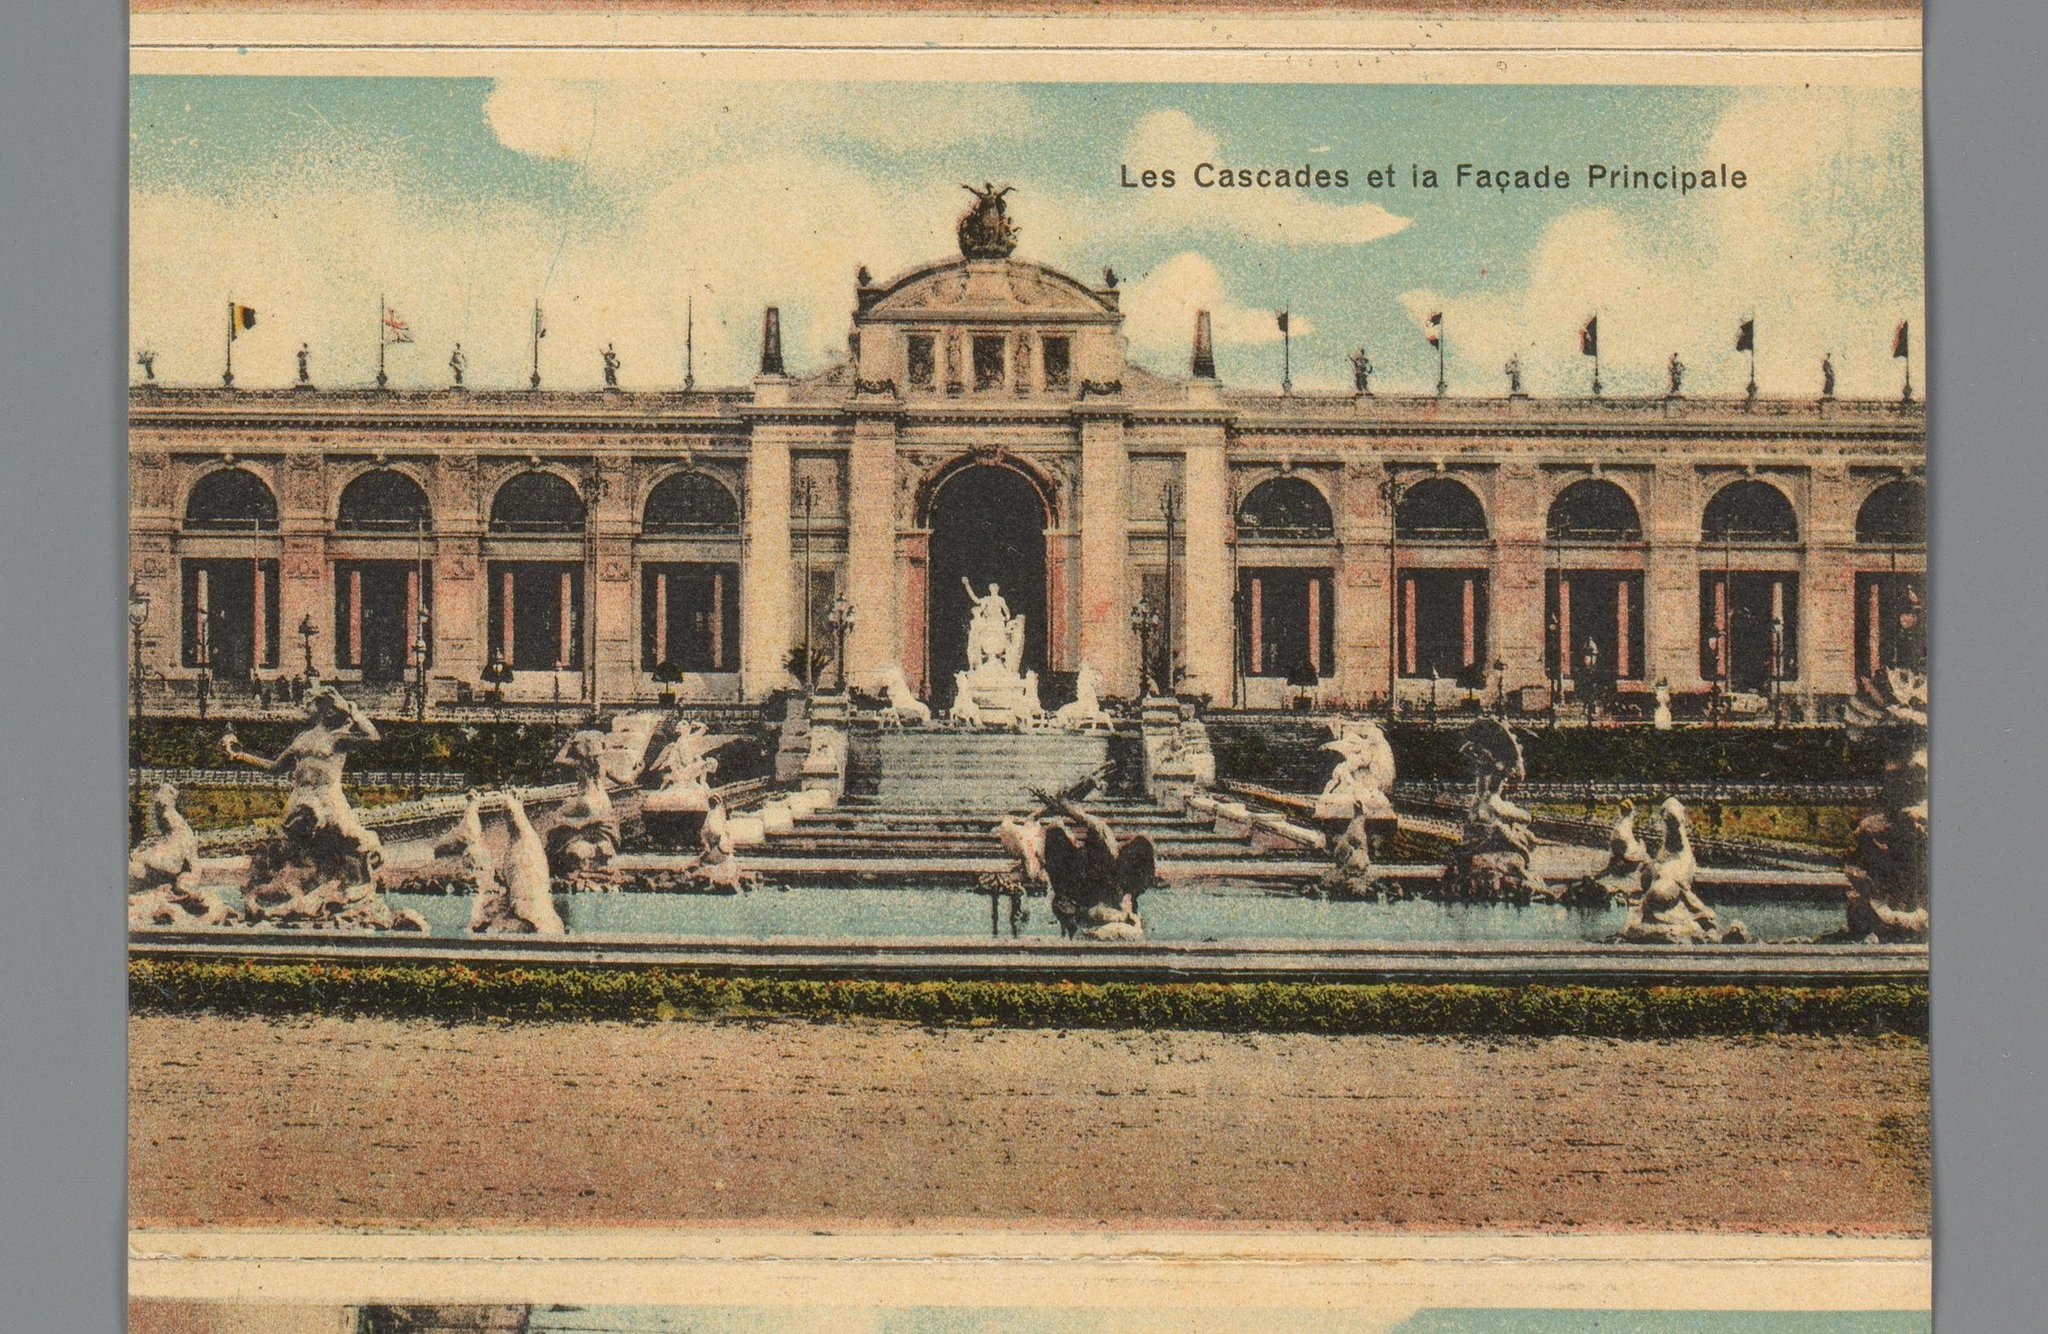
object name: photomechanical print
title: Les Cascades et la Façade Principale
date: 1910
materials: cardboard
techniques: photograph, lithograph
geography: brussels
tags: world fair, world exhibition, garden pond, edifice, e.g.: public building, department store, brussels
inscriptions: date